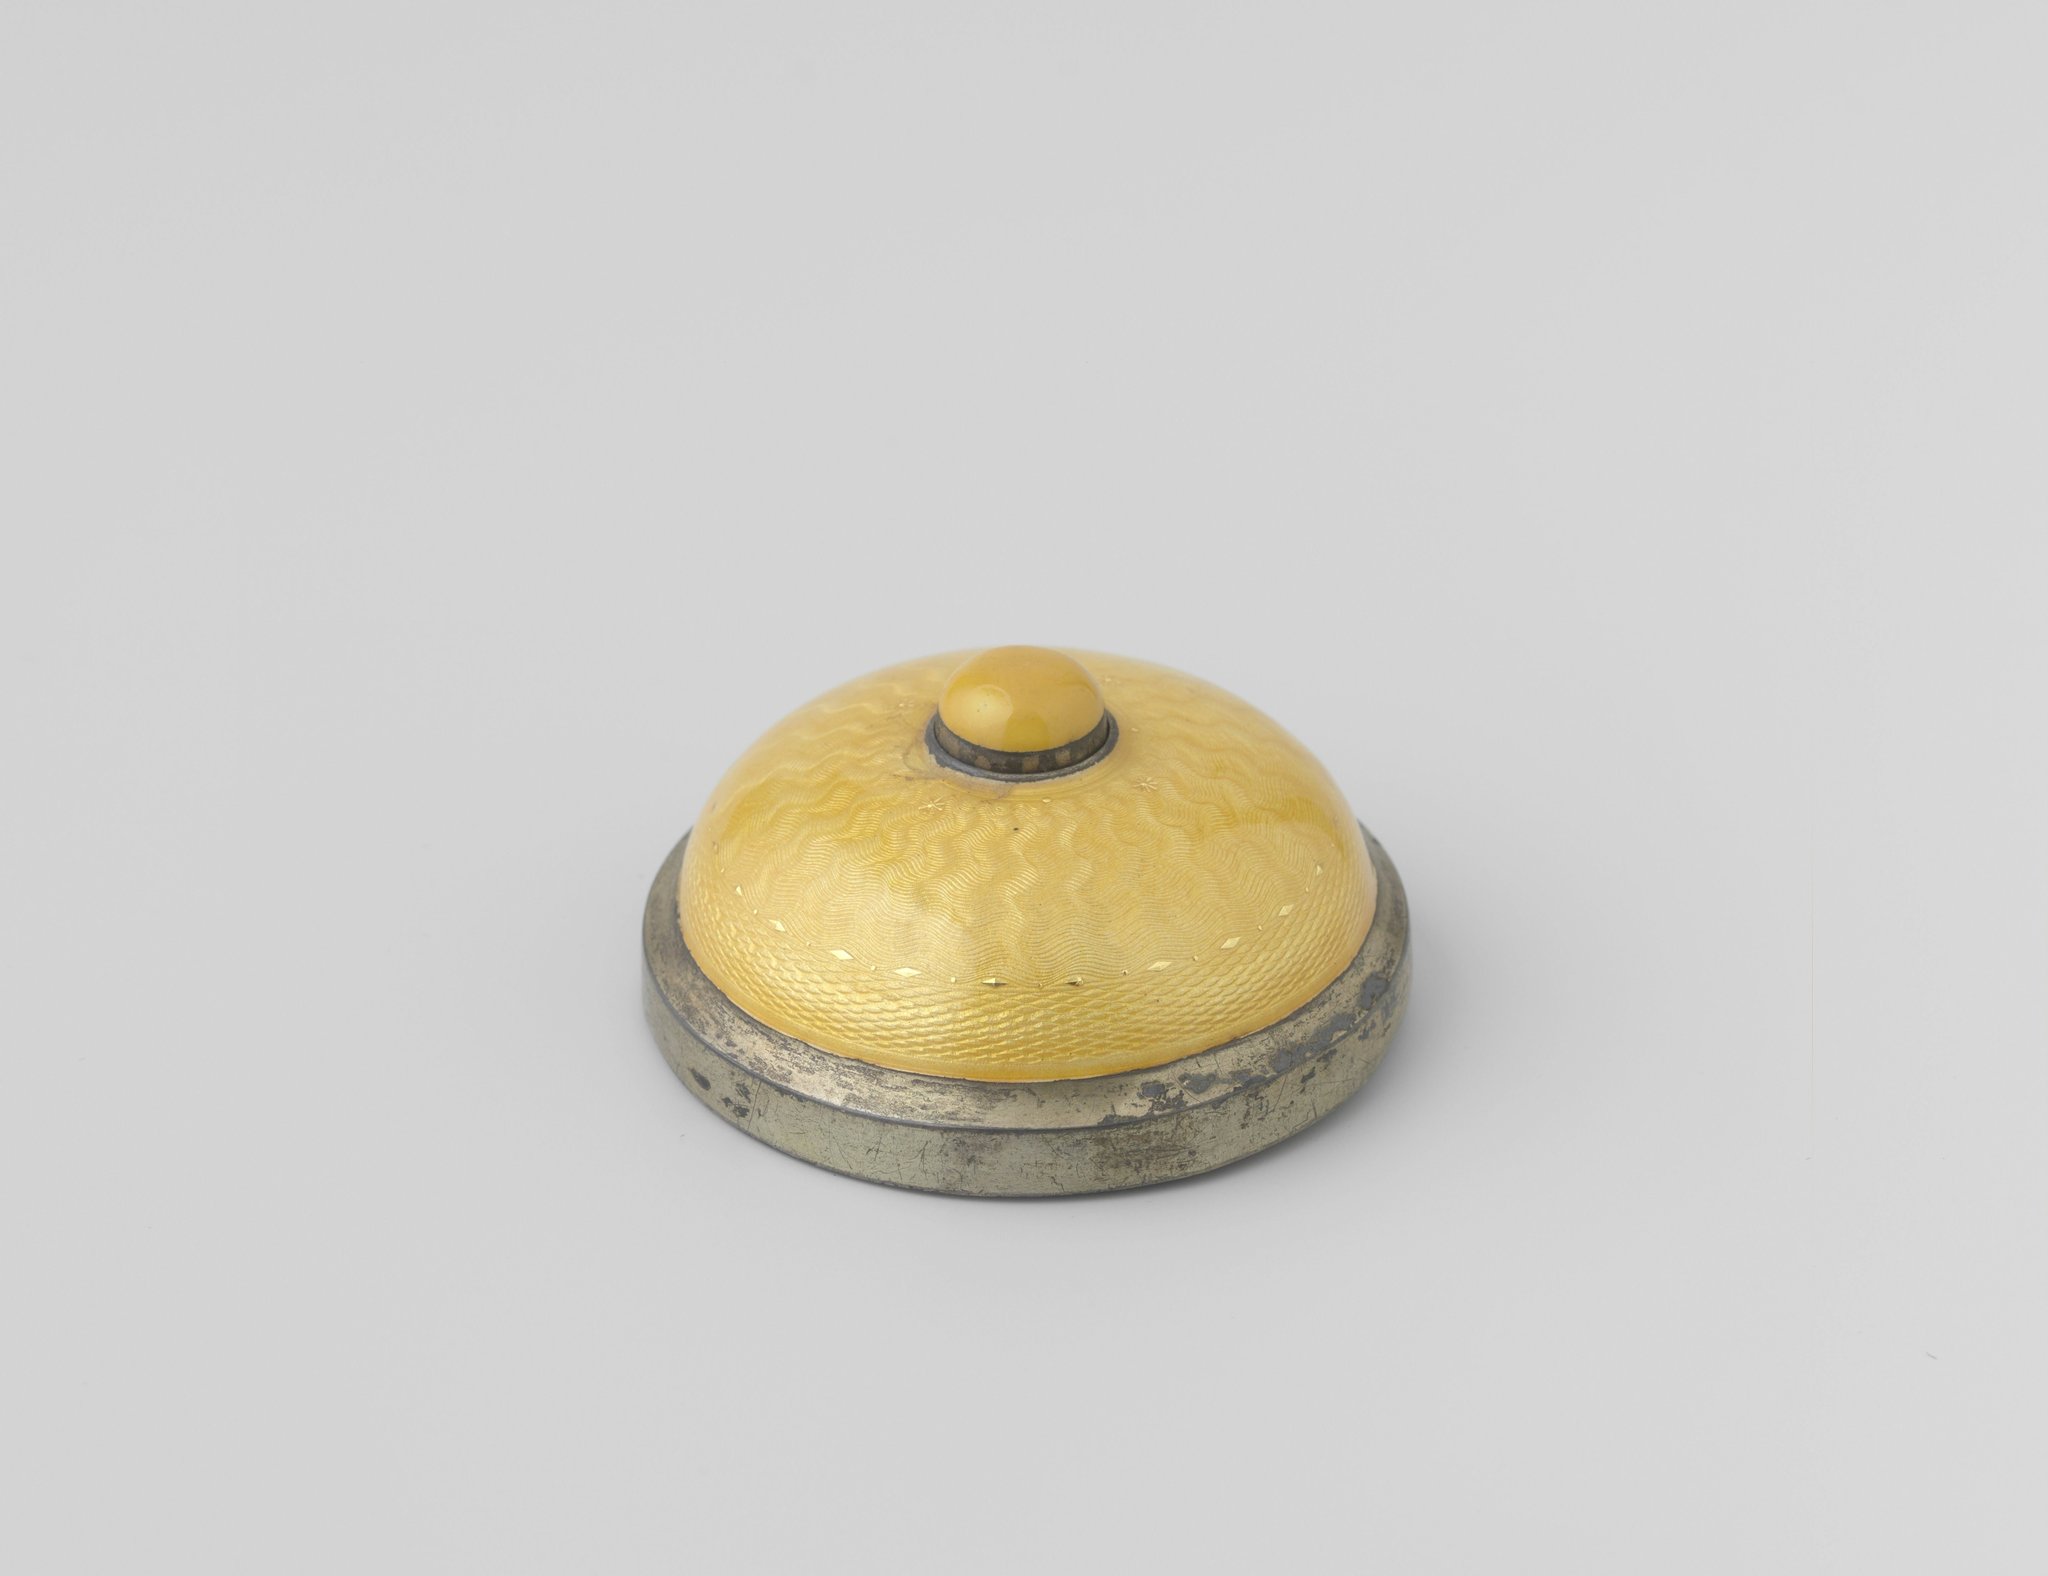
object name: jingle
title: Zilveren bel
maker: Anonymous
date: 1900-1925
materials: silver, wood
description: Elektrische bel van zilver. Een ronde, houten basis met zilveren rand, waarop een afgeplatte zilveren halve bol is aangebracht. De bol is versierd met een geel translucide email.